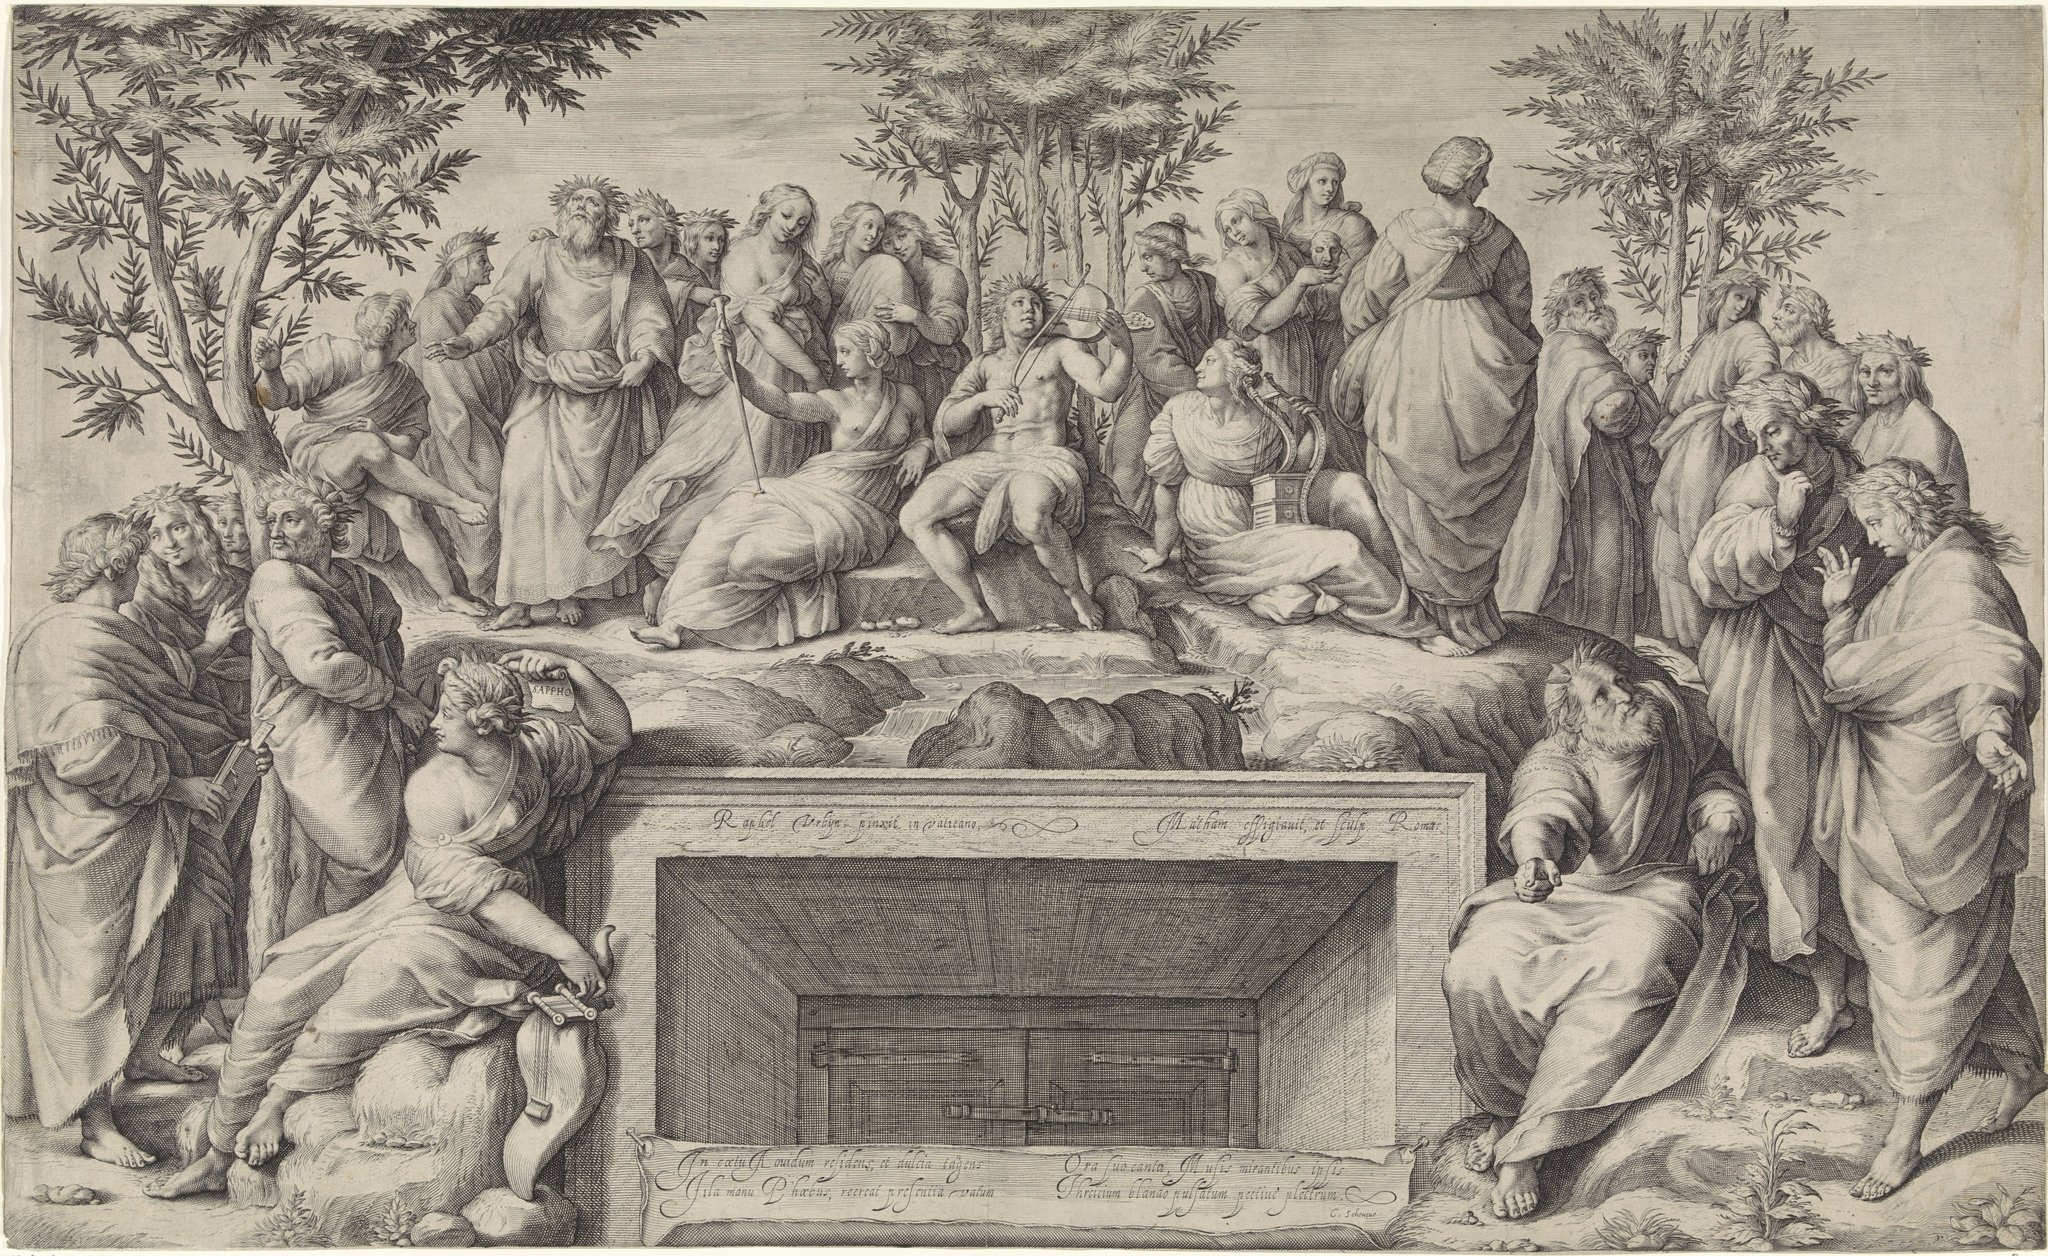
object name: print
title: Apollo op de Parnassus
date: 1594-1598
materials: paper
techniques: engraving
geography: rome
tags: (story of) sappho, the poetess, (story of) apollo (phoebus), parnassus, sacred to apollo musagetes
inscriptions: collector's mark: Lugt 240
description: Apollo, omringd door dichters en muzen, op de berg Parnassus. Links op de voorgrond de dichteres Sappho met haar naam op een vel papier in haar hand.